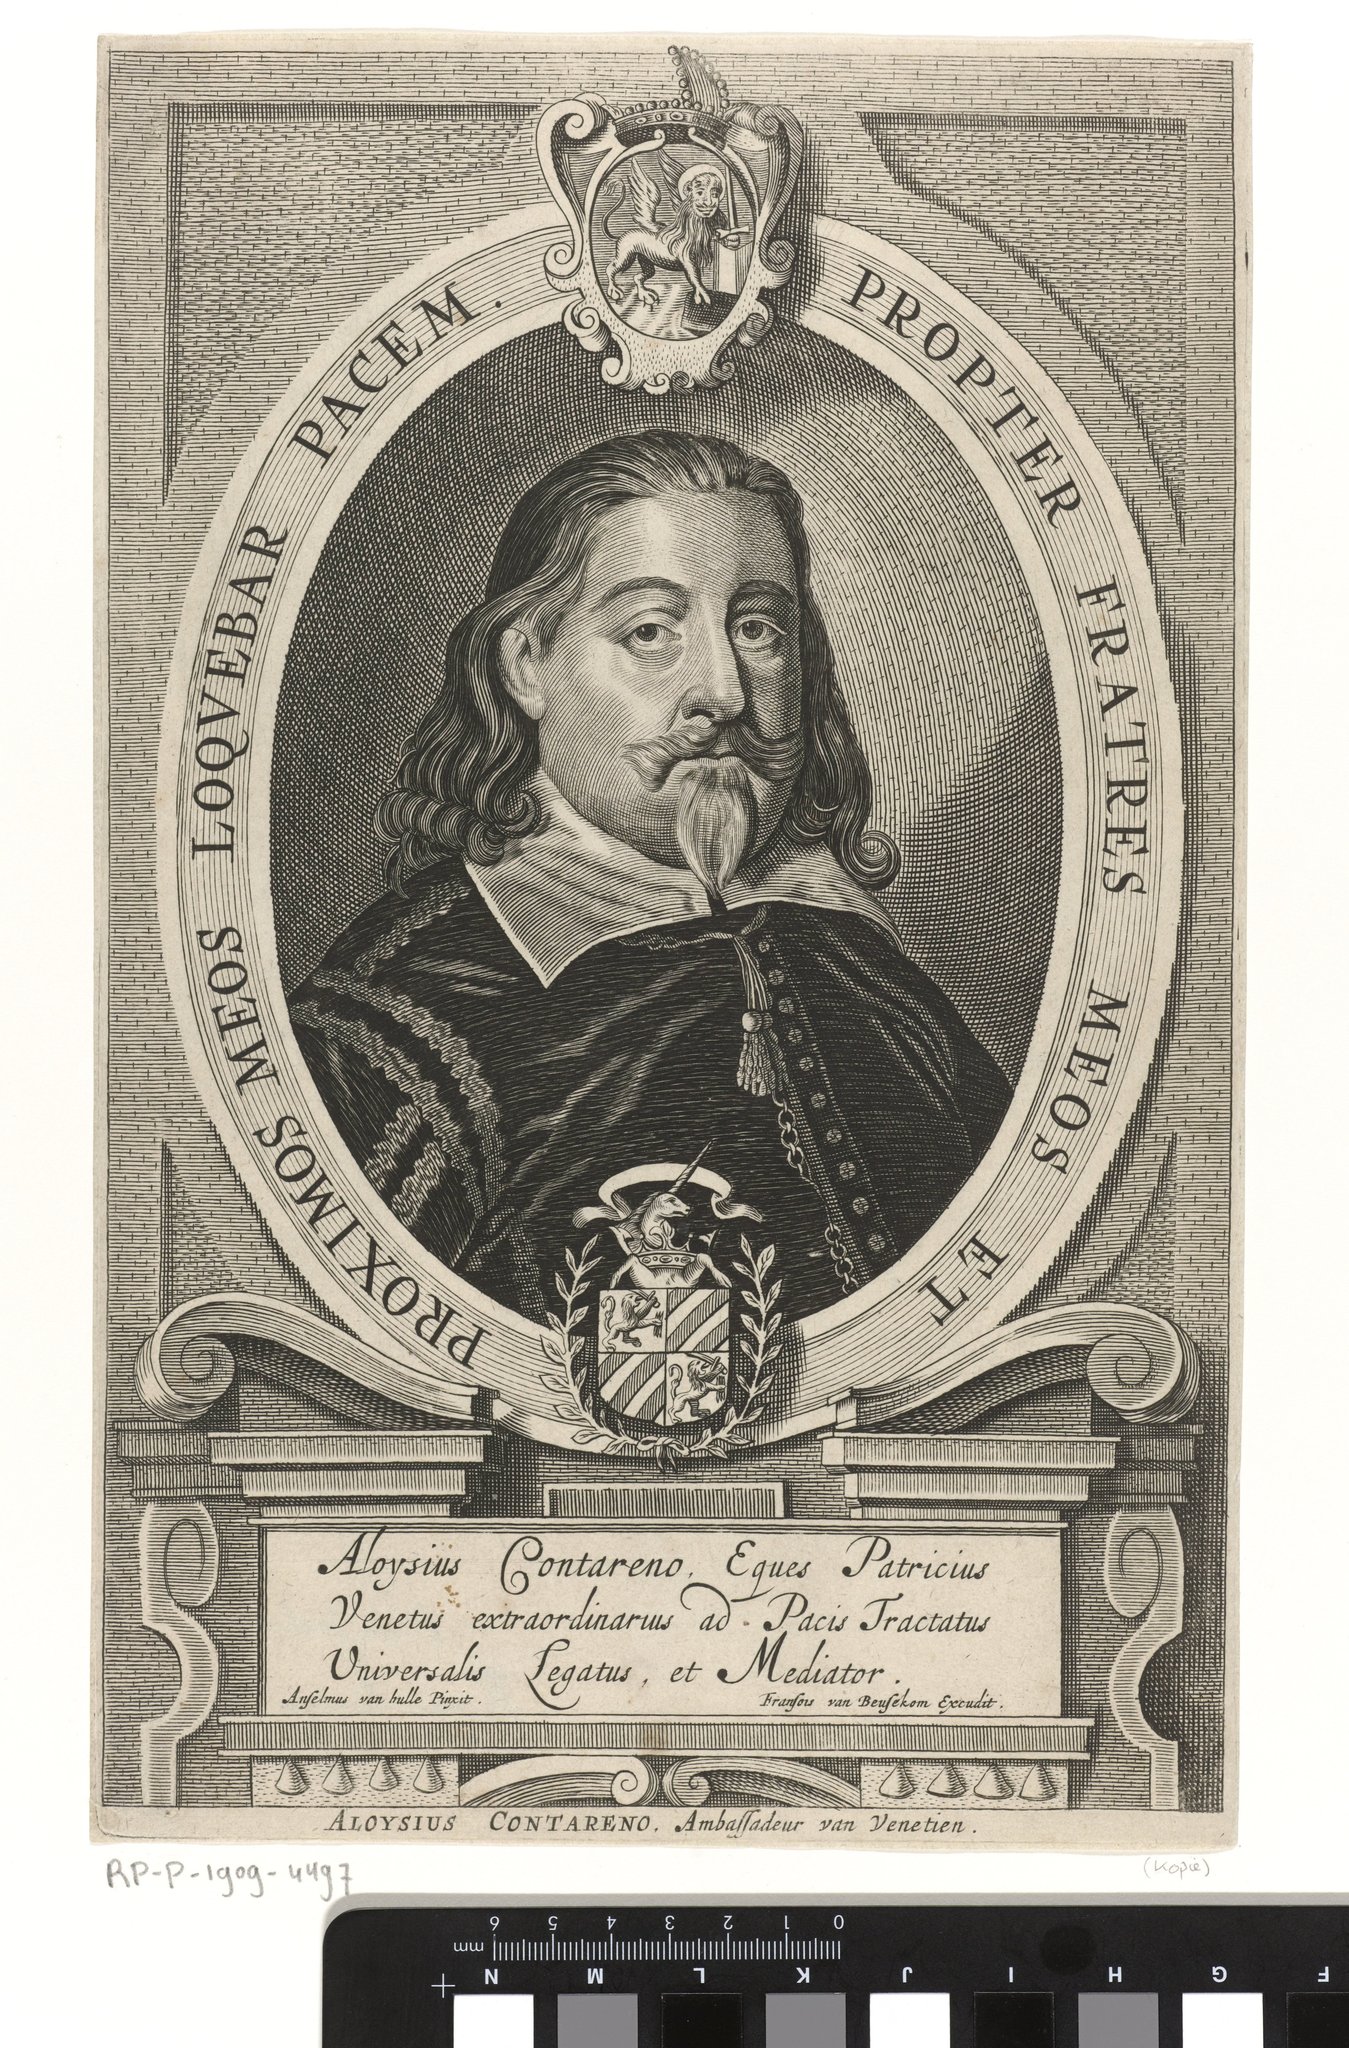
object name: print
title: Portret van Aloysius Contareno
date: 1616-1744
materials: paper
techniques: engraving, etching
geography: antwerp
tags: diplomaat, aloysius contareno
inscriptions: collector's mark: Lugt 2228a, collector's mark: Lugt 2228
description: Busteportret van Aloysius Contareno, Venetiaans diplomaat. Het portret is gevat in een ovale omlijsting met het wapenschild van de geportretteerde en een randschrift in het Latijn. In het kader een drieregelig onderschrift in het Latijn. In de marge de naam en functie van de geportretteerde in het Nederlands. Kopie in spiegelbeeld naar de gelijknamige prent van Pieter de Jode II uit een serie portretten naar schilderijen van Anselmus van Hulle van alle gedelegeerden bij de vredesonderhandelingen te Münster en Osnabrück.